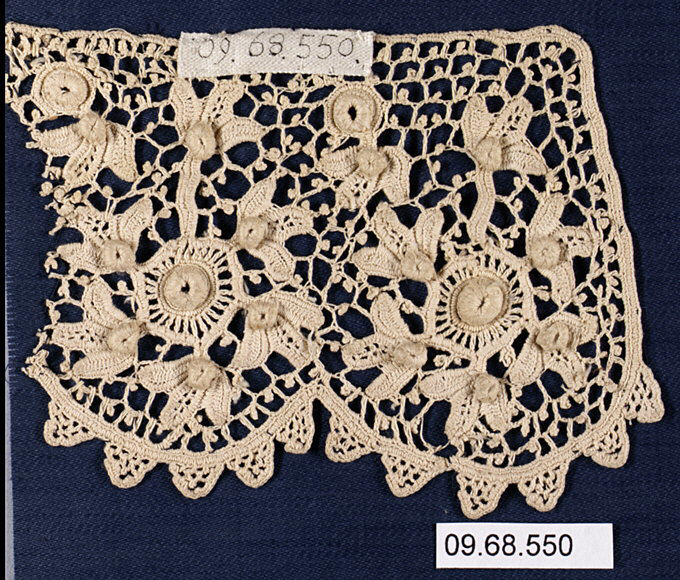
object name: specimen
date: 1801-1900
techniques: crochet